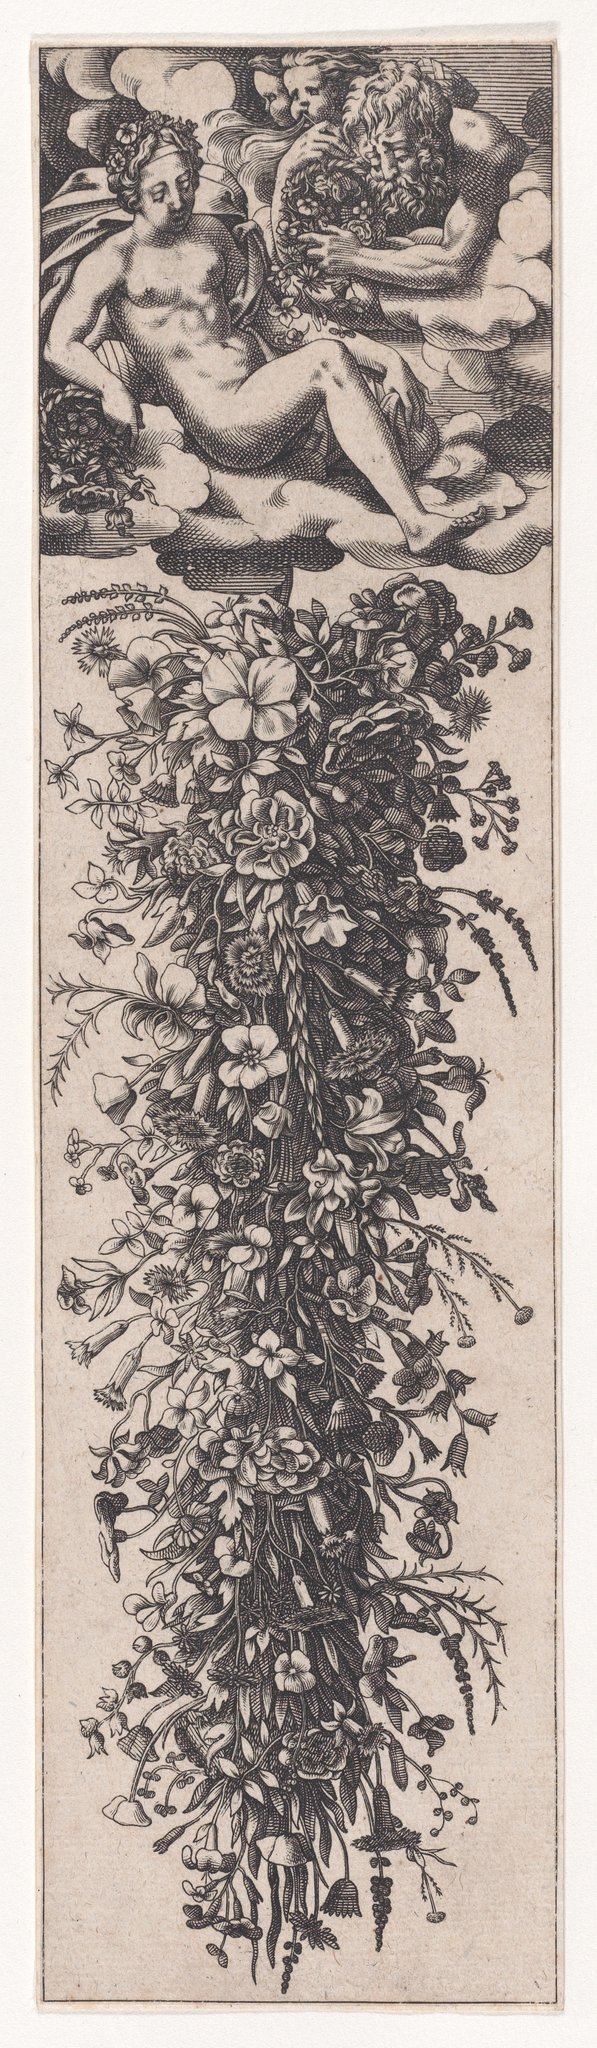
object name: print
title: Flora Receiving Flowers and Festoon of Flowers, from "Dessins d'aiguières, etc., no. 5"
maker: rené boyvin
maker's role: artist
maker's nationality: french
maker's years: 1525-1598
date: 1525-1600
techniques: engraving